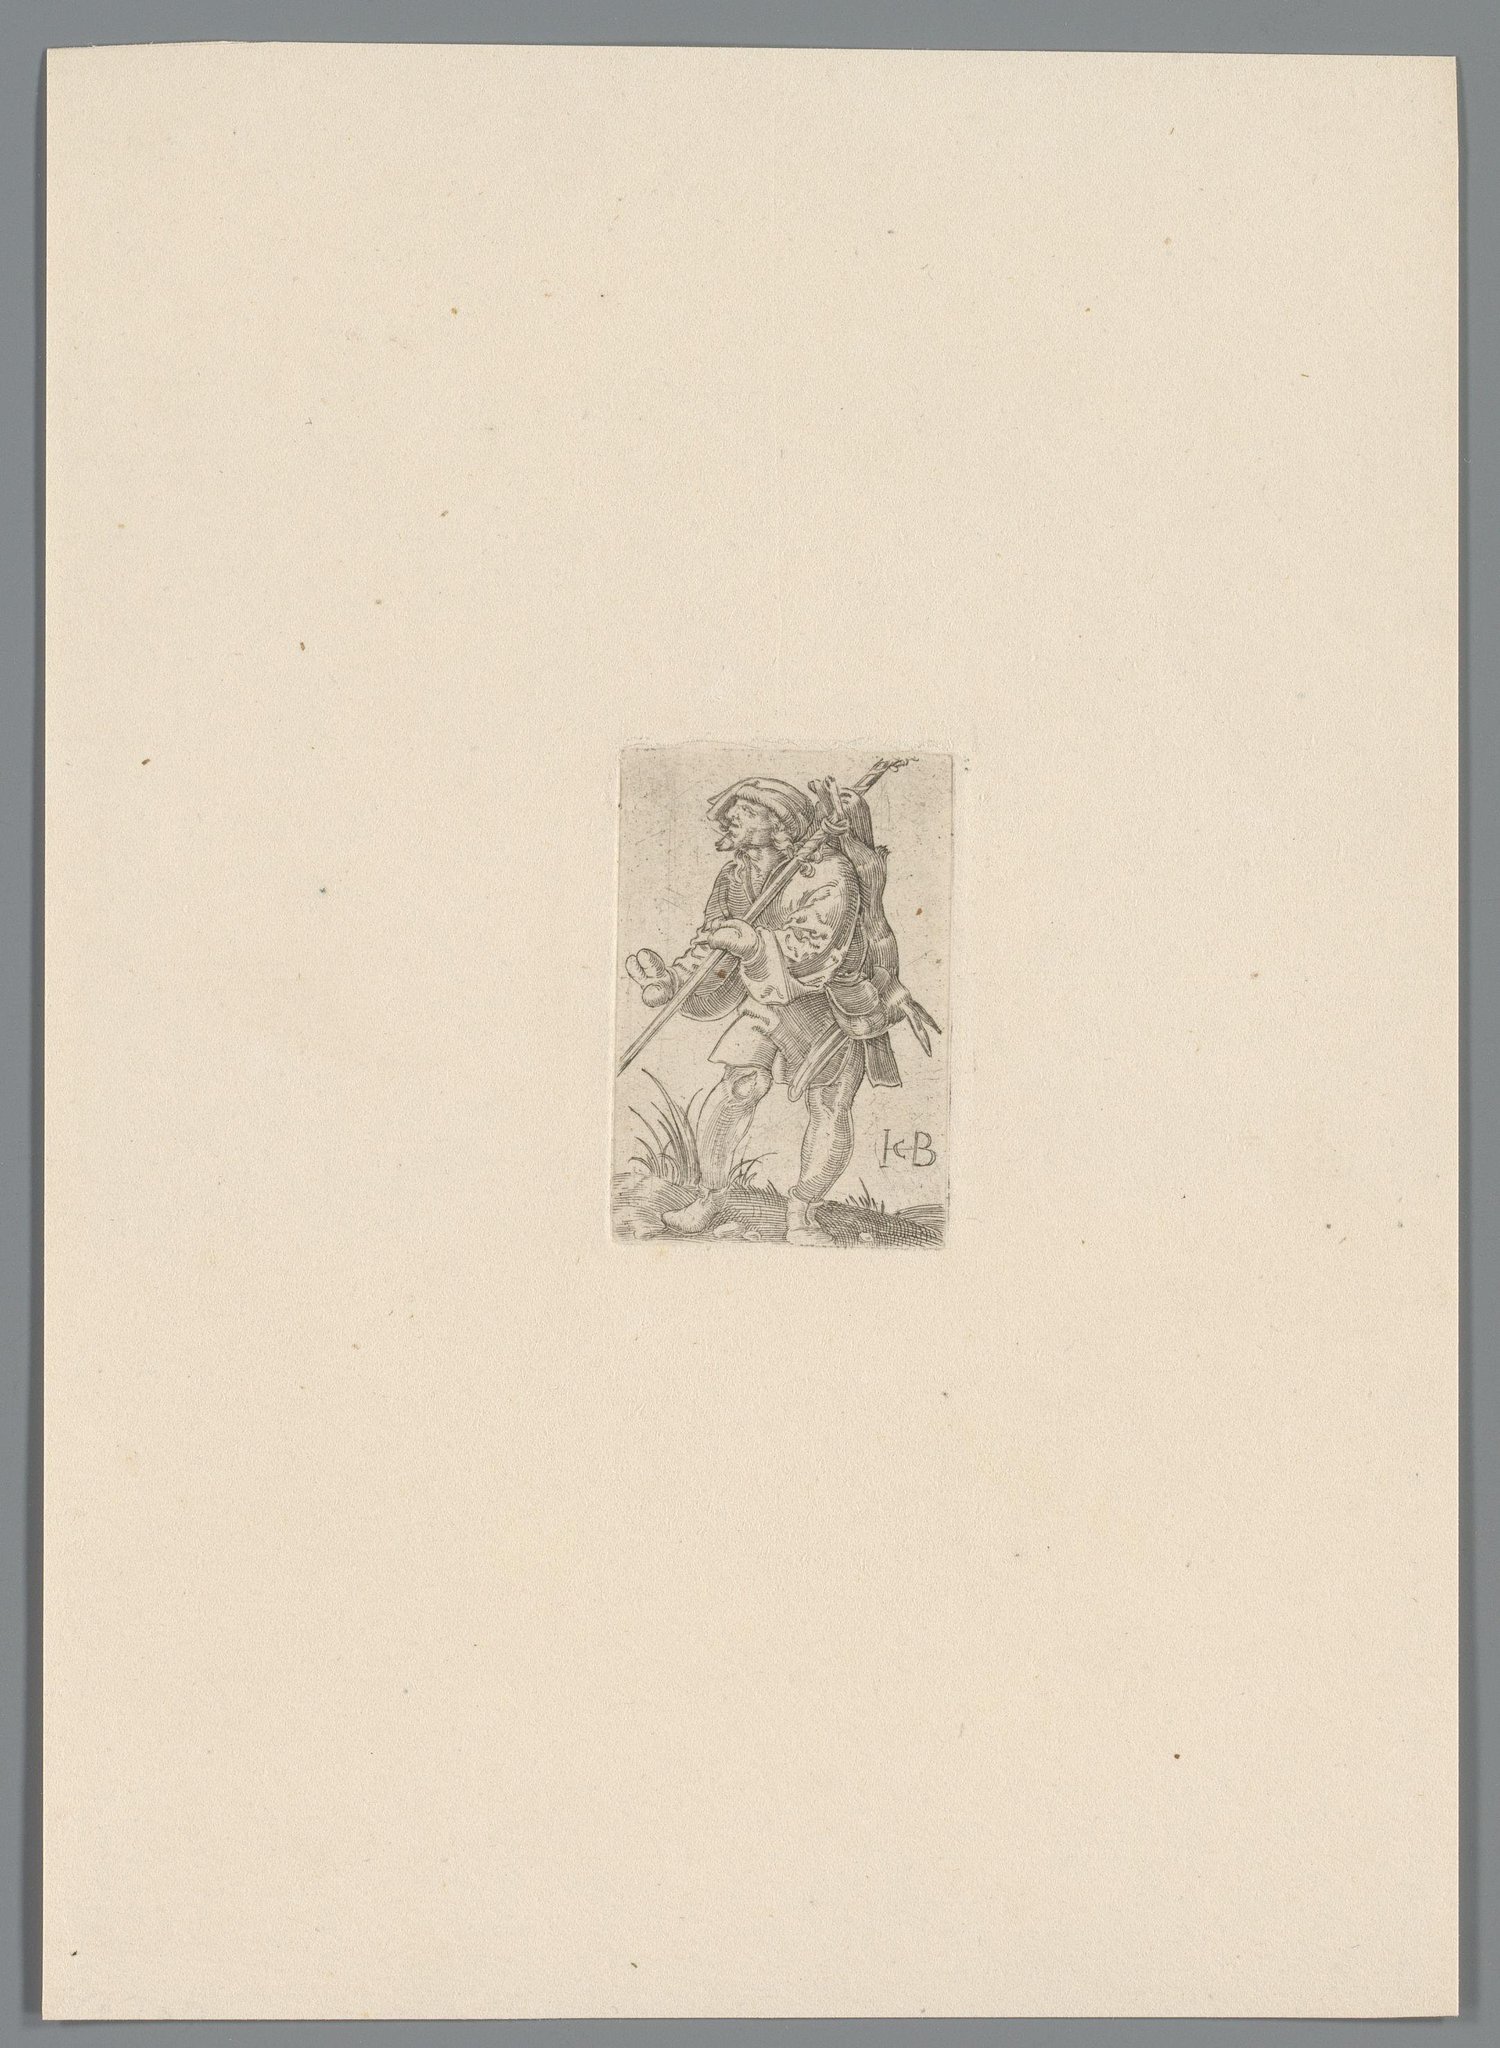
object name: print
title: Boer met gevangen haas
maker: jacob binck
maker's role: painter, print maker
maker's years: 1494-1569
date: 1510-1569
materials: paper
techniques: engraving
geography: germany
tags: rodents: hare, farmers